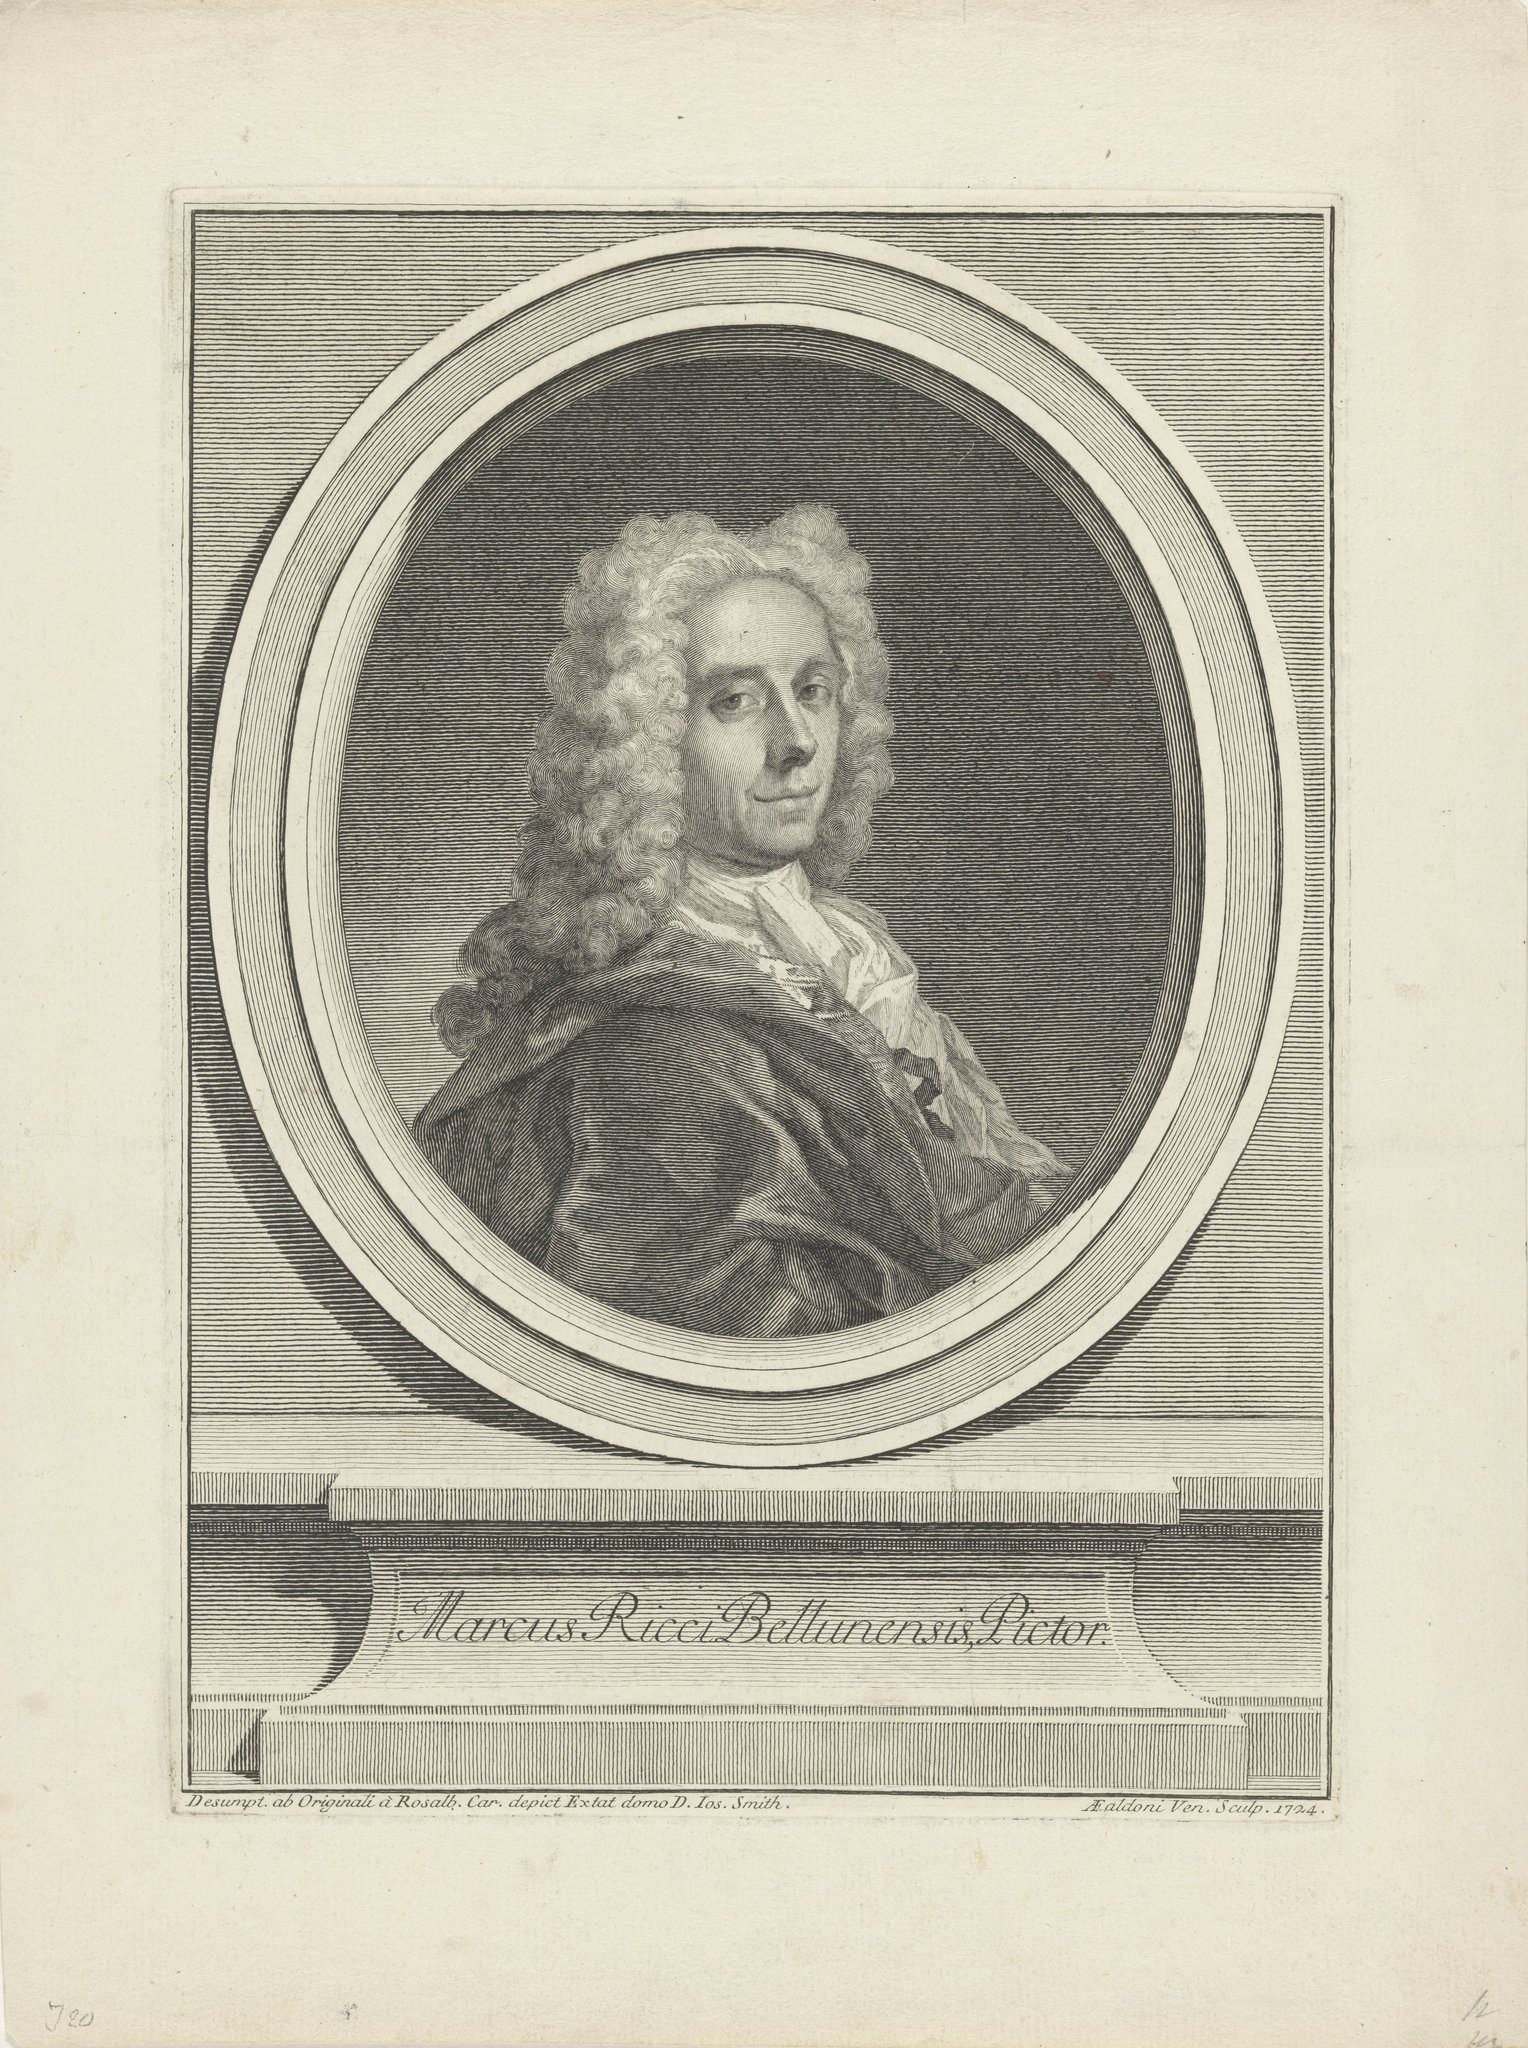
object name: print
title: Portret van schilder Marco Ricci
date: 1724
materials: paper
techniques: engraving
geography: venice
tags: venice, painter, print maker, draughtsman, marco ricci, historical persons, portrait, self-portrait of artist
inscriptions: collector's mark: Lugt 2228